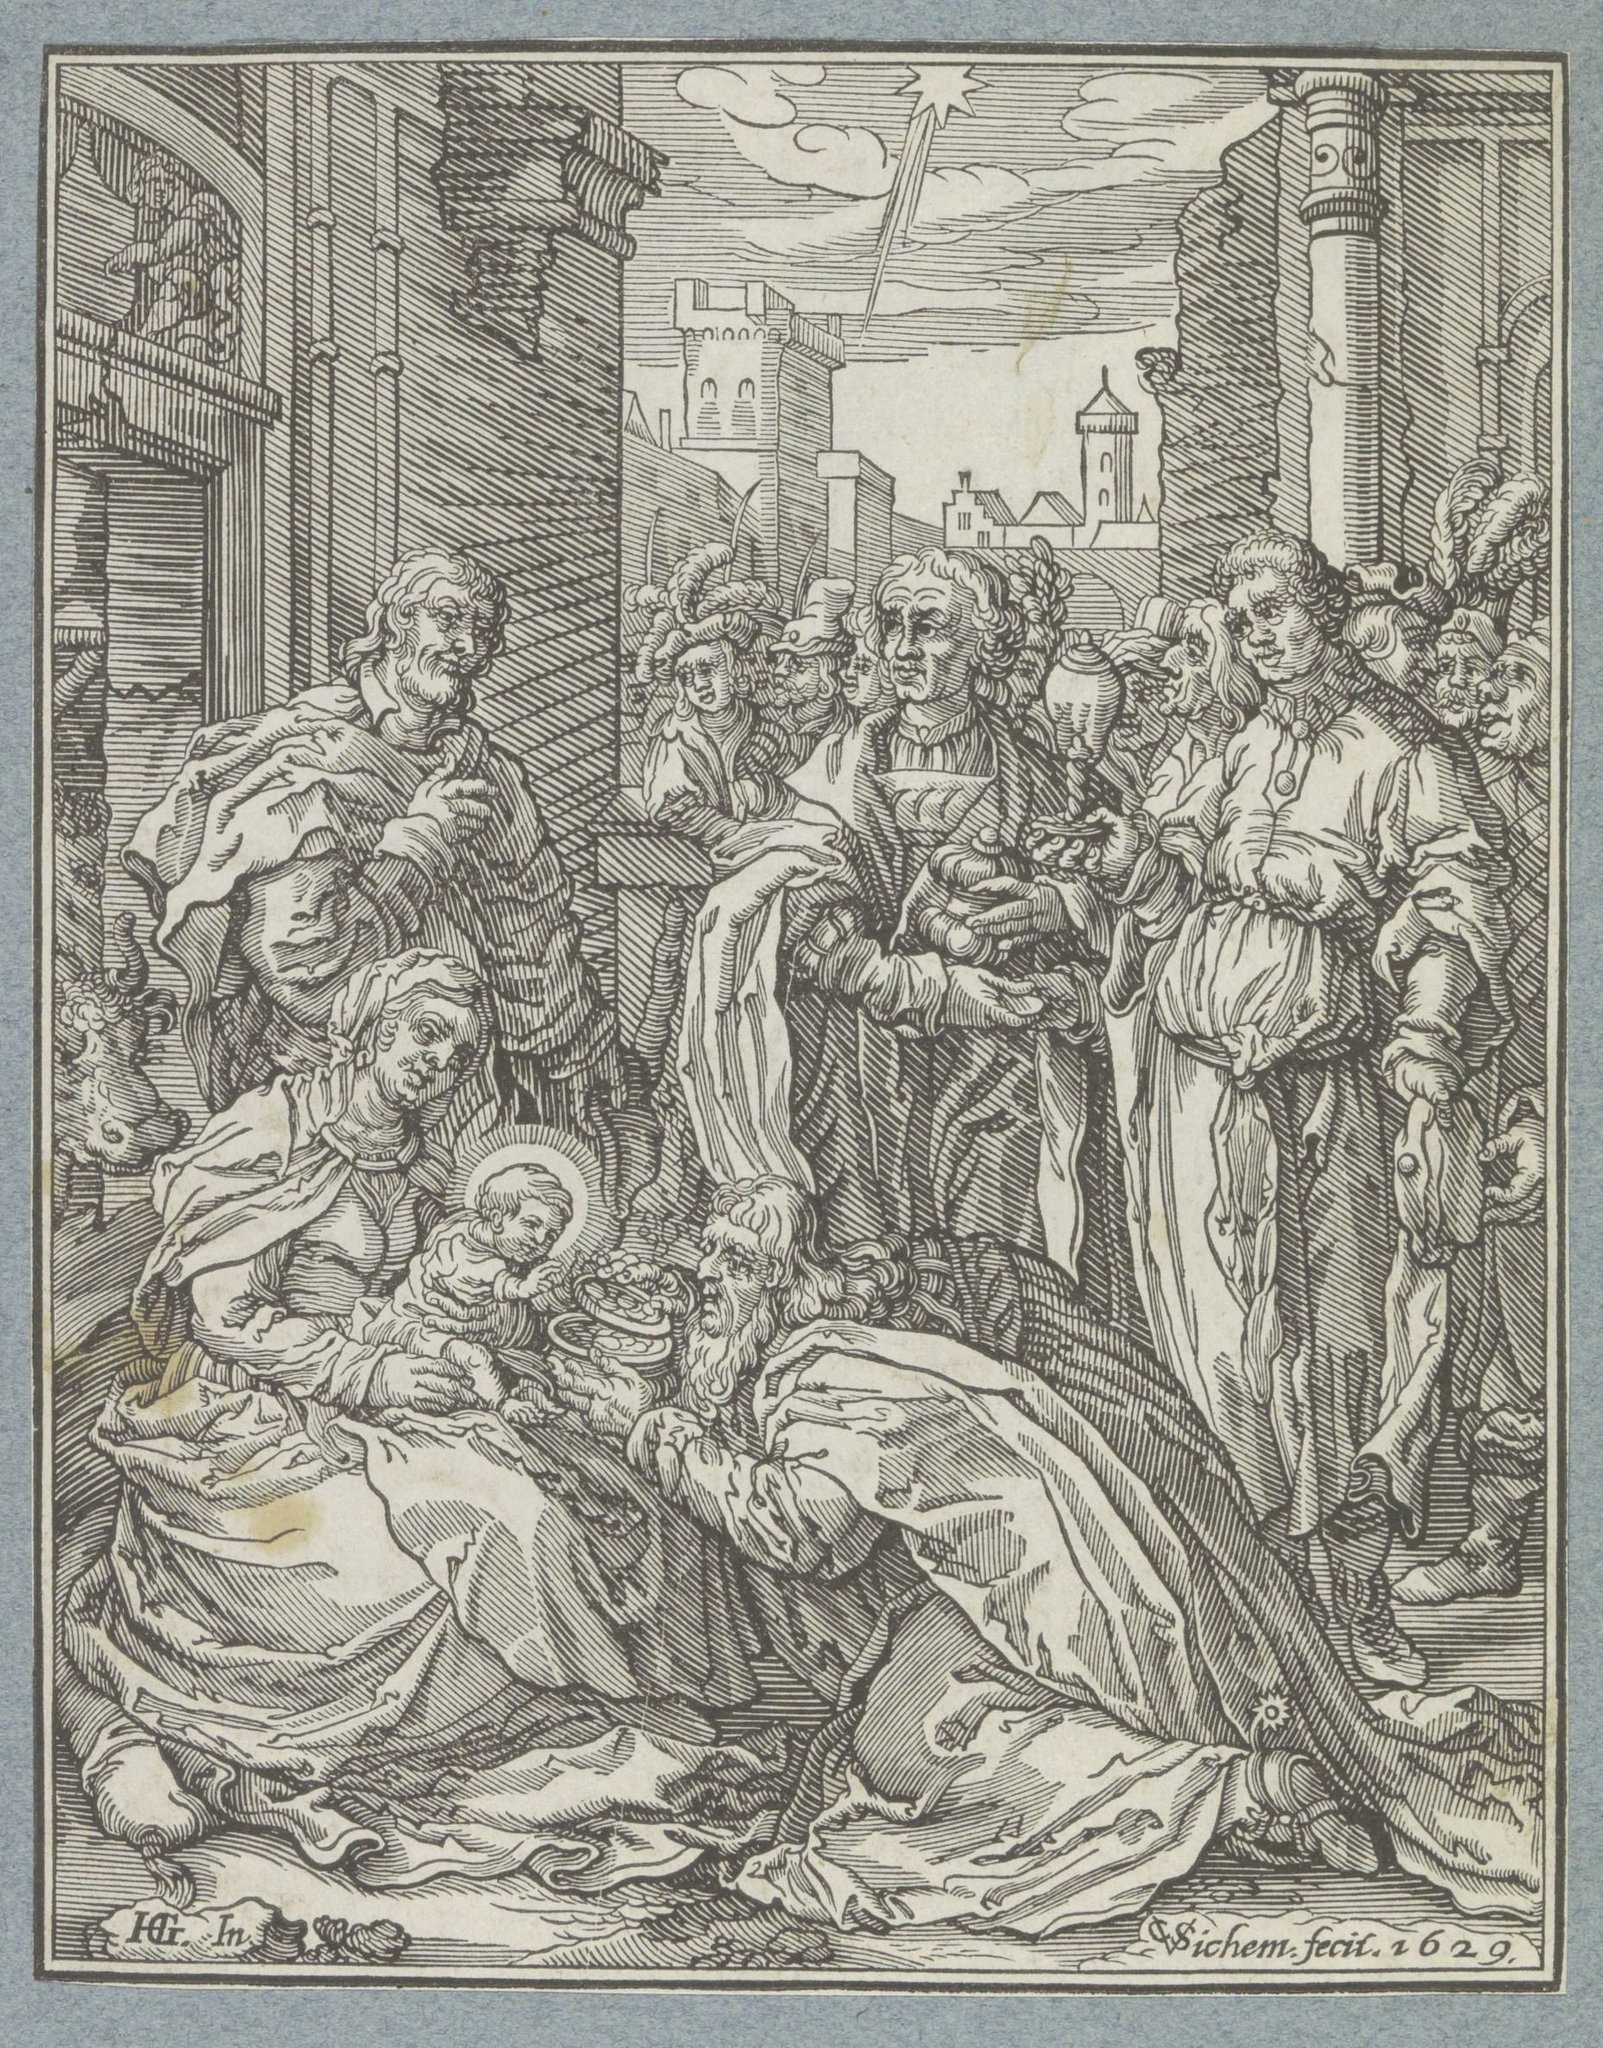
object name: album leaf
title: Jeugd van Christus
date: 1629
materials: paper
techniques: woodcut, pasting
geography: amsterdam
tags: adoration of the kings: the wise men present their gifts to the christ-child (gold, frankincense and myrrh)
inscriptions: date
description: Jozef en Maria bij de stal. De drie koningen brengen hun geschenken en aanbidden het Christuskind, dat op schoot zit bij Maria. Achter hen staan mannen uit hun gevolg. De prent maakt deel uit van een album.